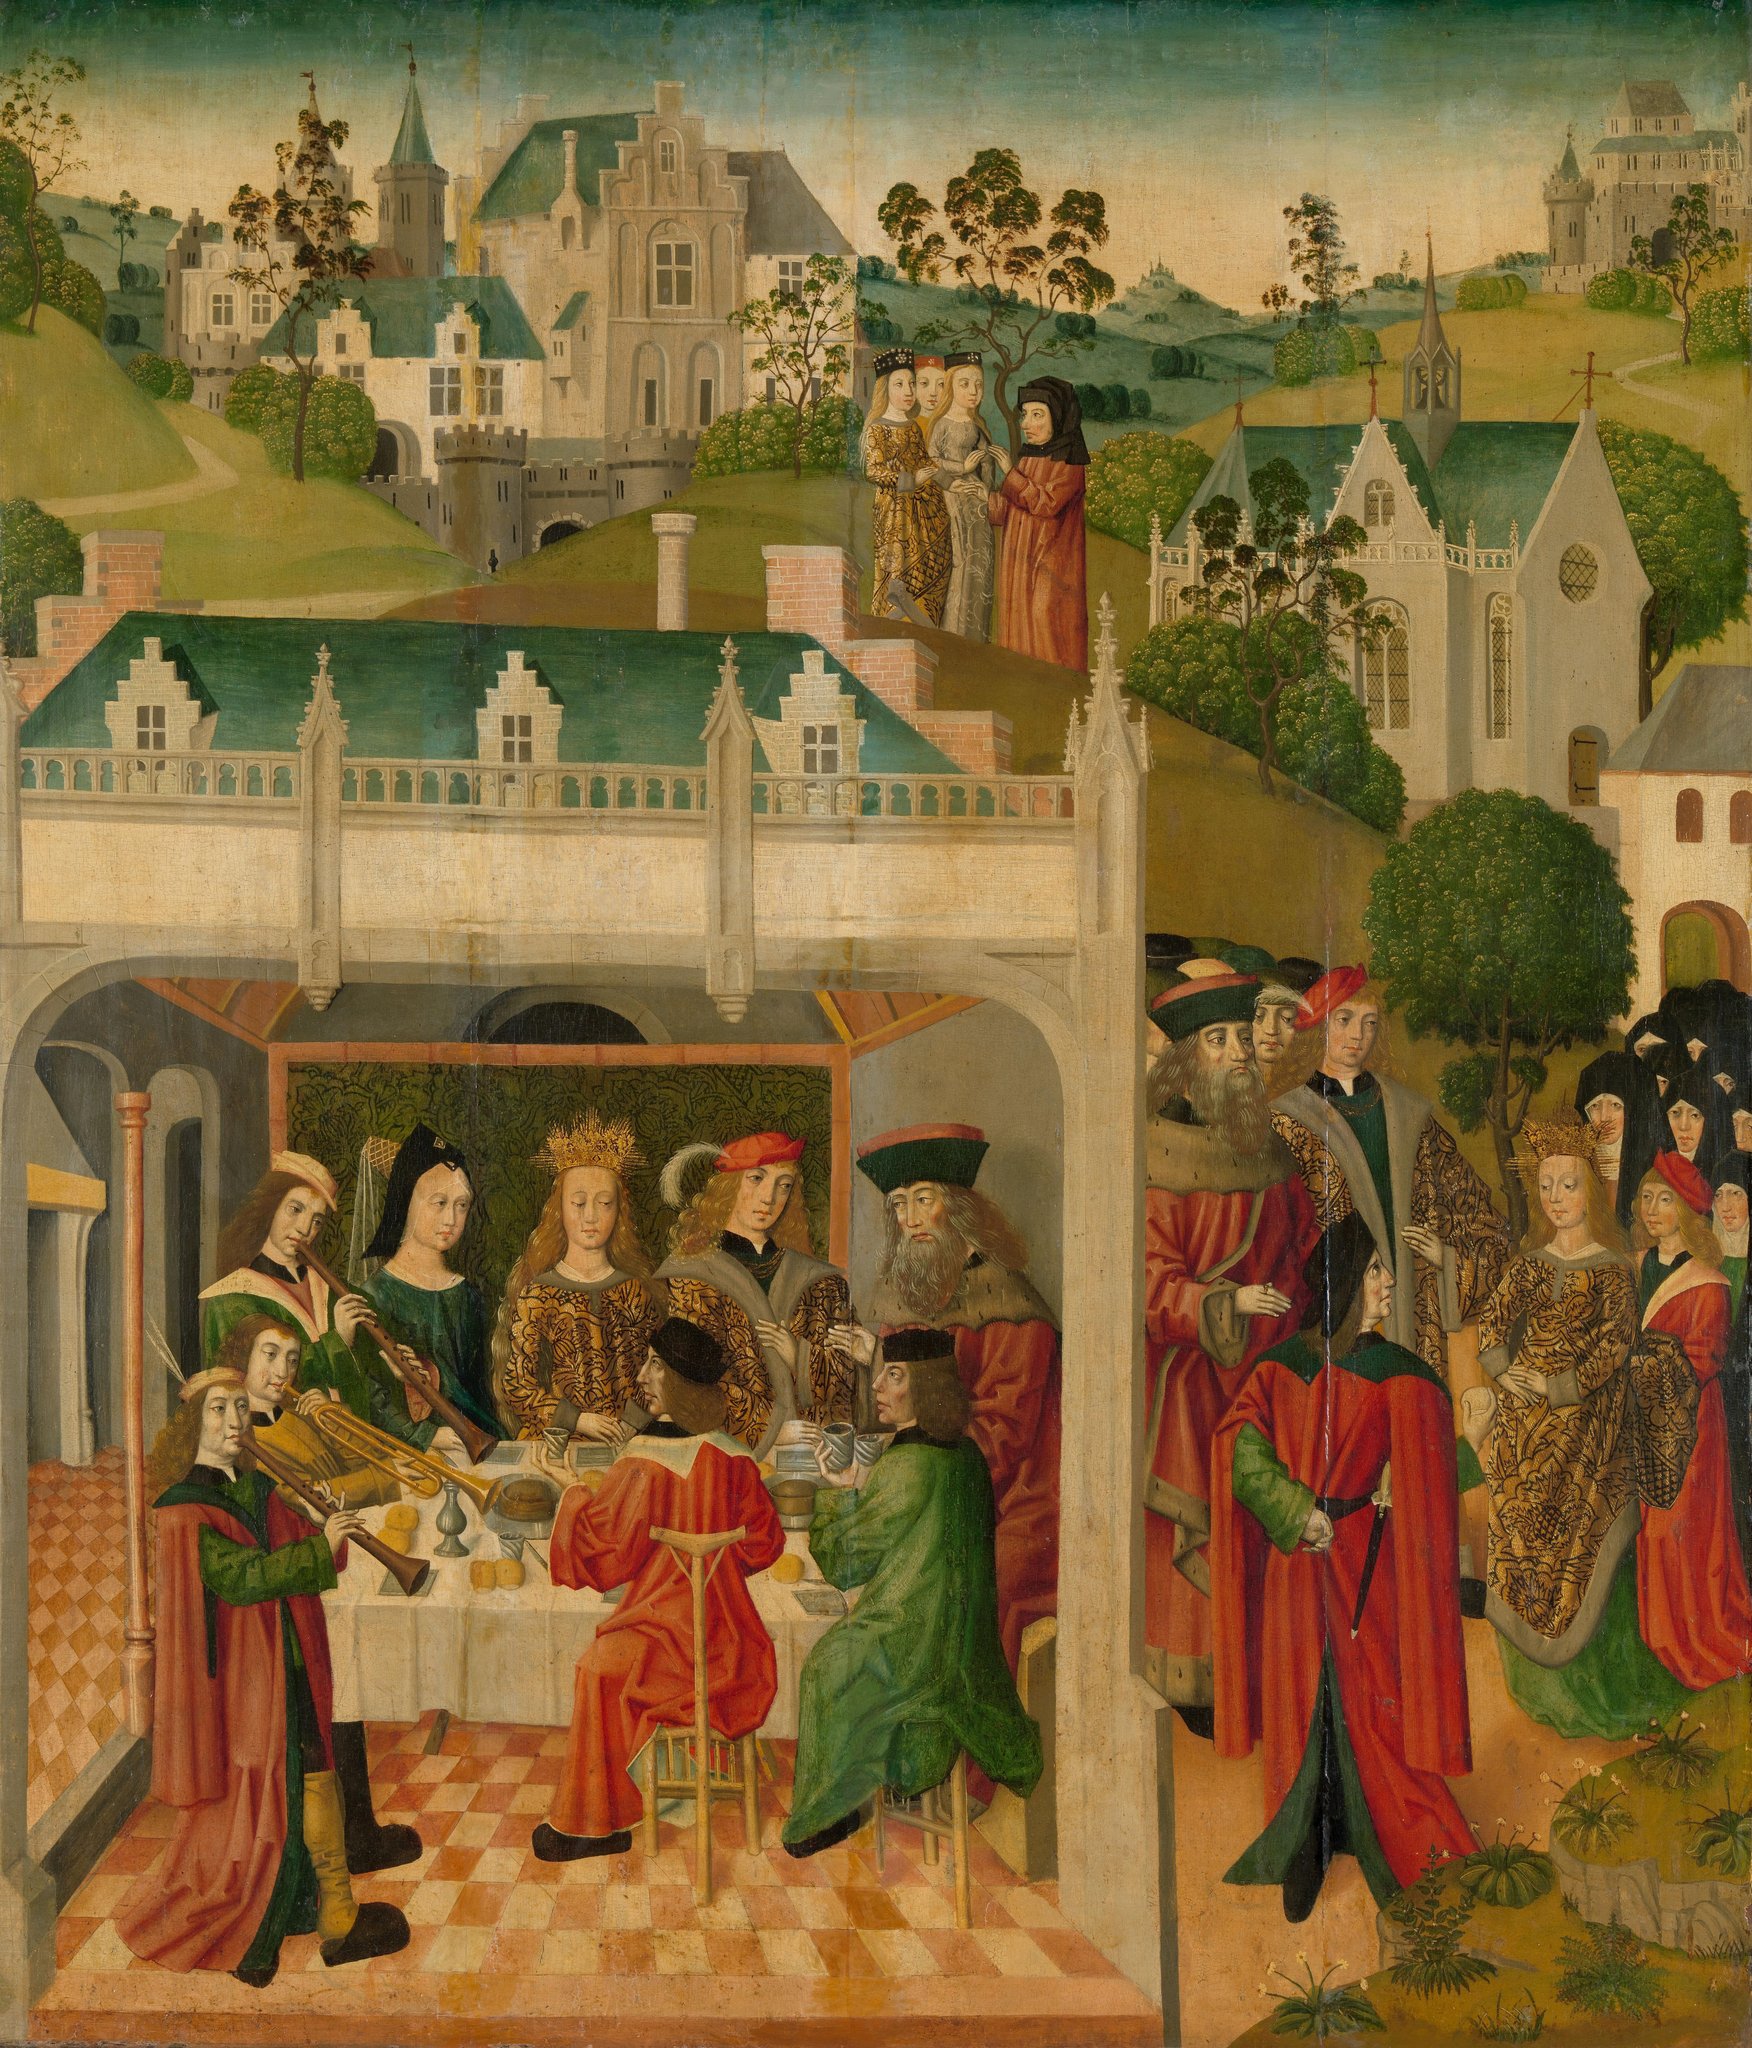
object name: painting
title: Wedding Feast of Saint Elizabeth of Hungary and Louis of Thuringia in the Wartburg, inner left wing of an altarpiece made for the Grote Kerk in Dordrecht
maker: master of the st elizabeth panels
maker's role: painter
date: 1490-1495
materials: oil, panel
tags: wedding feast, wedding meal, the wife and widow of the landgrave of thuringia, and franciscan tertiary, elisabeth of hungary; possible attributes: beggar, cripple, fish, loaves, leper, model of church, pitcher, roses in lap, scald-head, three crowns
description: Scènes uit het leven van de heilige Elisabeth van Hongarije. Rechts op de voorgrond de verloving met hertog Lodewijk van Thüringen en Hessen in de tuin. Links het bruiloftsmaal op de Wartburg waaraan ook koning Andreas, de vader van de bruid, en de moeder van de bruidegom deelnamen. Drie muzikanten met fluiten en een bazuin musiceren bij het feestmaal. Op de achtergrond een landschap met kastelen en de gebouwen van een stad. Elisabeth, vergezeld van twee dienaressen Gutha en Isentrudis, belooft aan haar geestelijke leider Koenraad van Marburg gehoorzaamheid en kuisheid. Binnenzijde van het linkerpaneel, maakt deel uit van twee panelen, aan weerszijden beschilderd met voorstellingen uit het leven van de heilige Elisabeth van Hongarije (1207-31) en de Sint Elisabethsvloed 18-19 november 1421 (SK-A-3145/46 en SK-A-3147A/B).